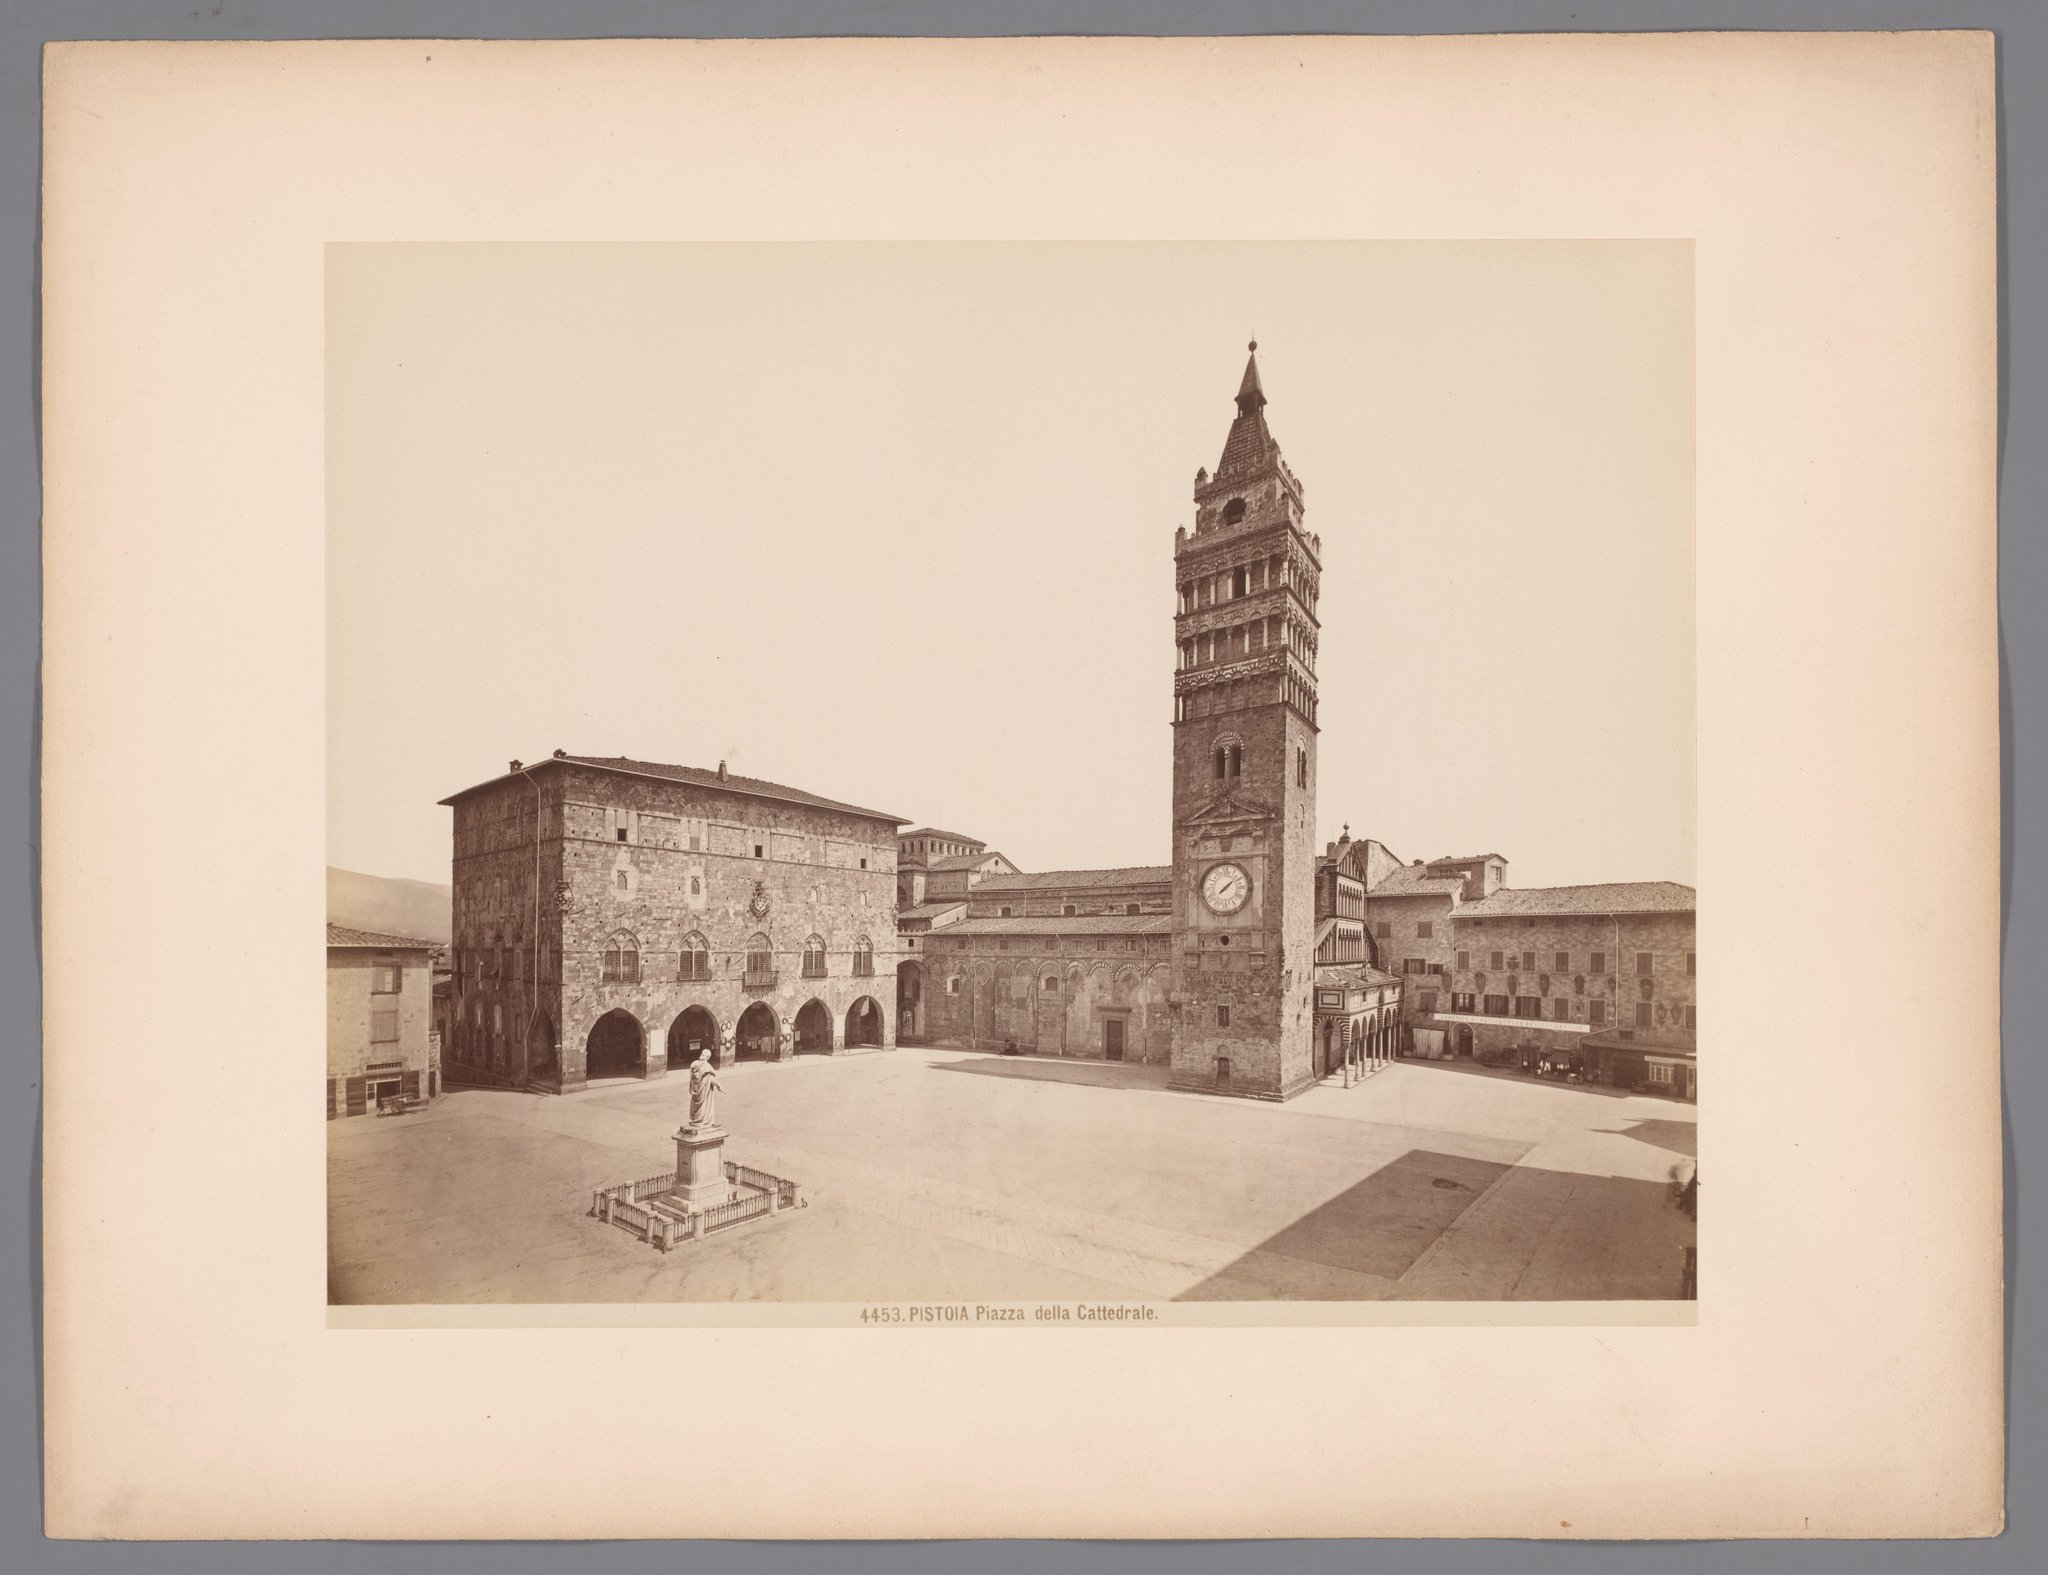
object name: photograph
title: Piazza della Cattedrale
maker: giacomo brogi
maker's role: fotograaf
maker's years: 1822-1881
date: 1864-1881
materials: cardboard, paper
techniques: albumen print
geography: pistoia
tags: square, place, circus, etc., tower, clock tower ~ monumental adornment, church (exterior)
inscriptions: number: ‘4453.’, inscription: ‘Brogi’